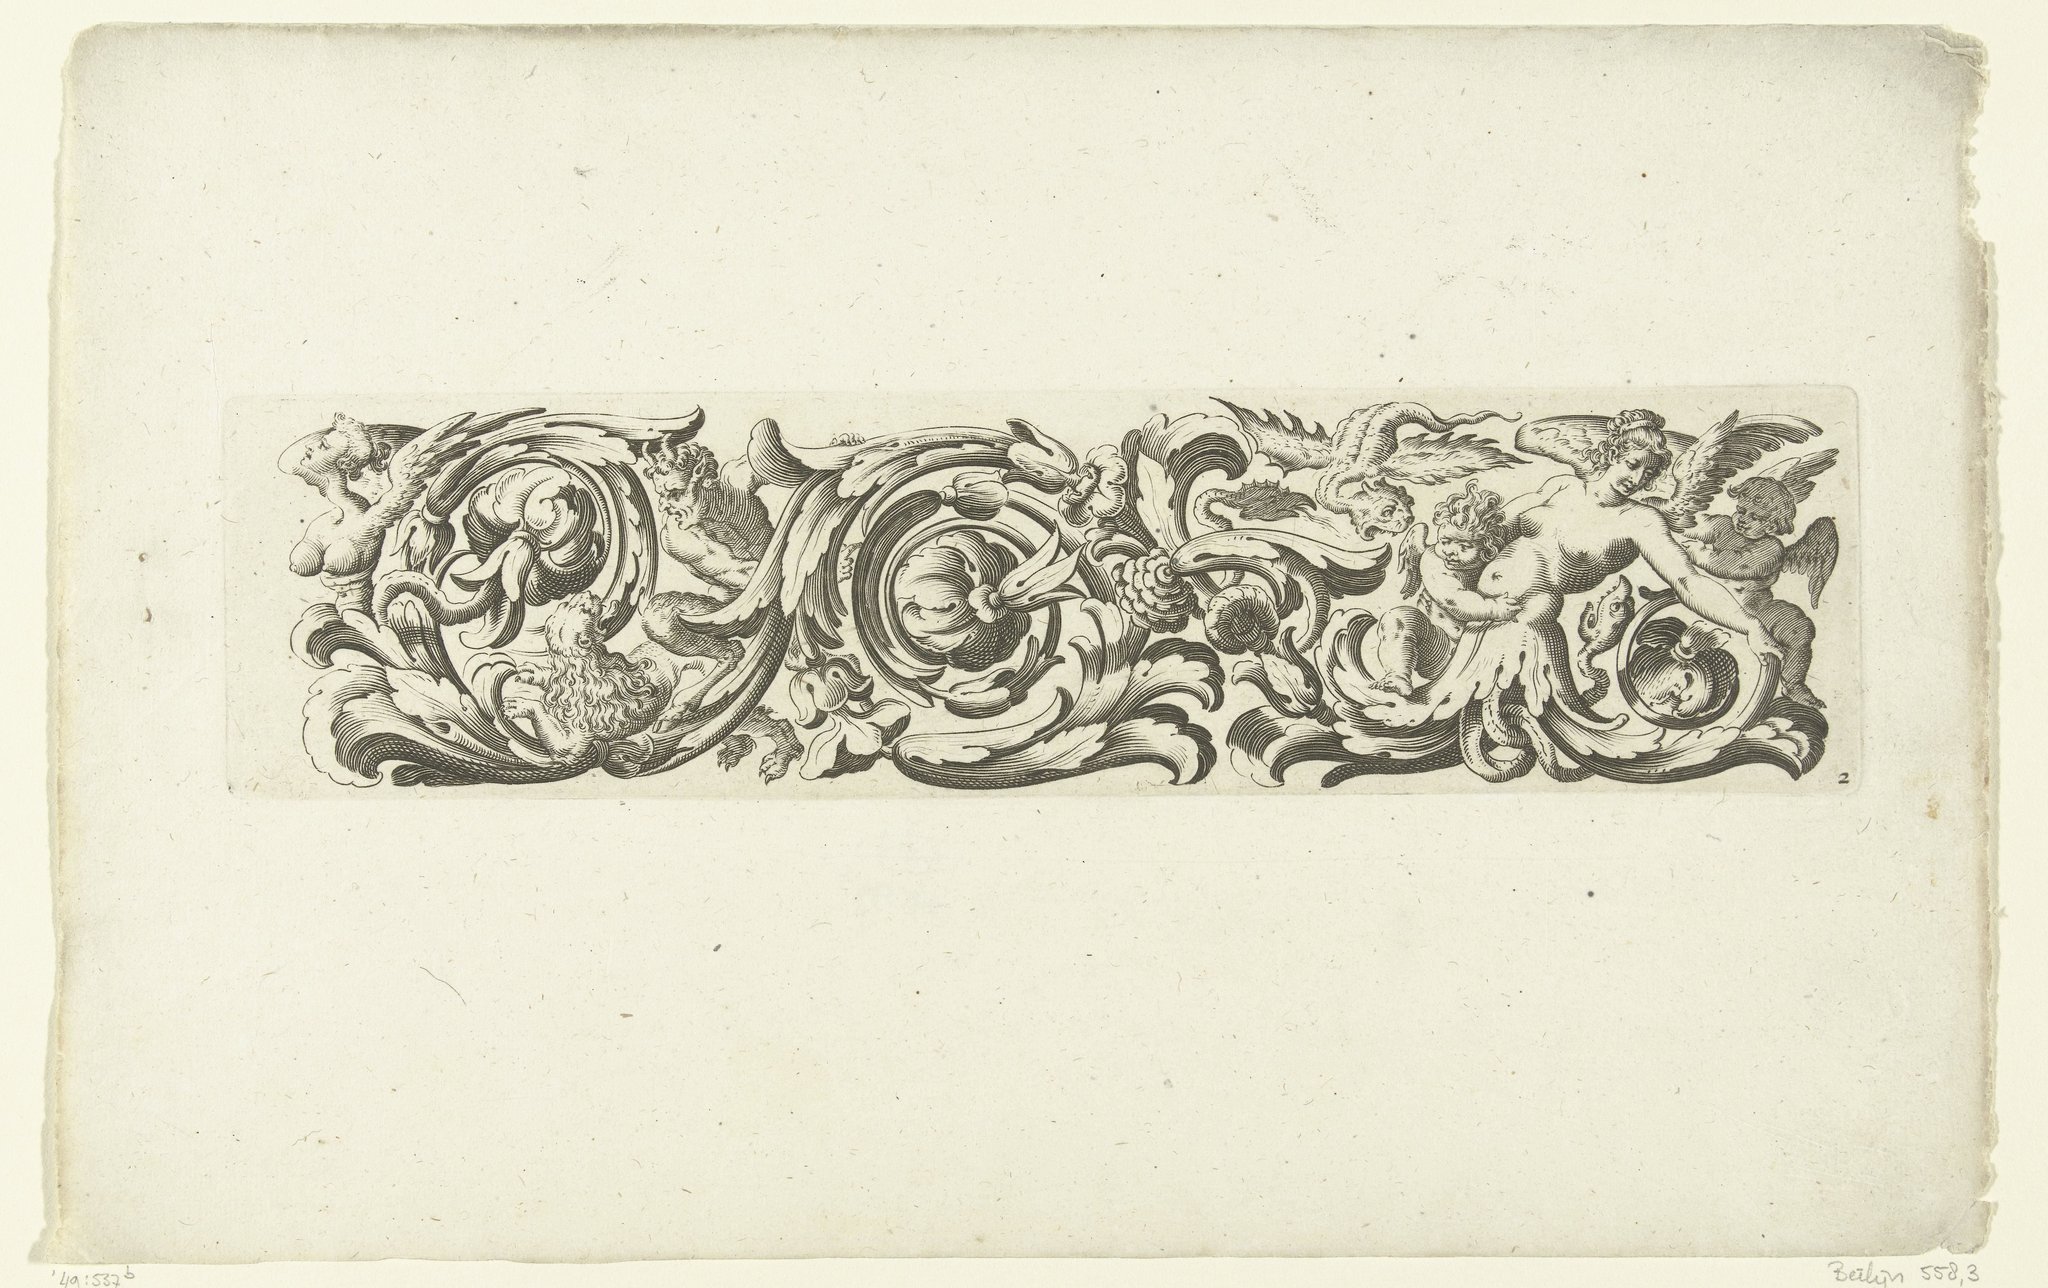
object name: print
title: Bladrank met gevleugelde vrouw rechts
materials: paper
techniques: engraving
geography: amsterdam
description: De vrouw wordt vergezeld door twee putti. Blad 2 uit serie met Nederlandse tegenzijdige verkleinde kopieën van de serie Disegnii Varii Di Polifilo Zancarli.